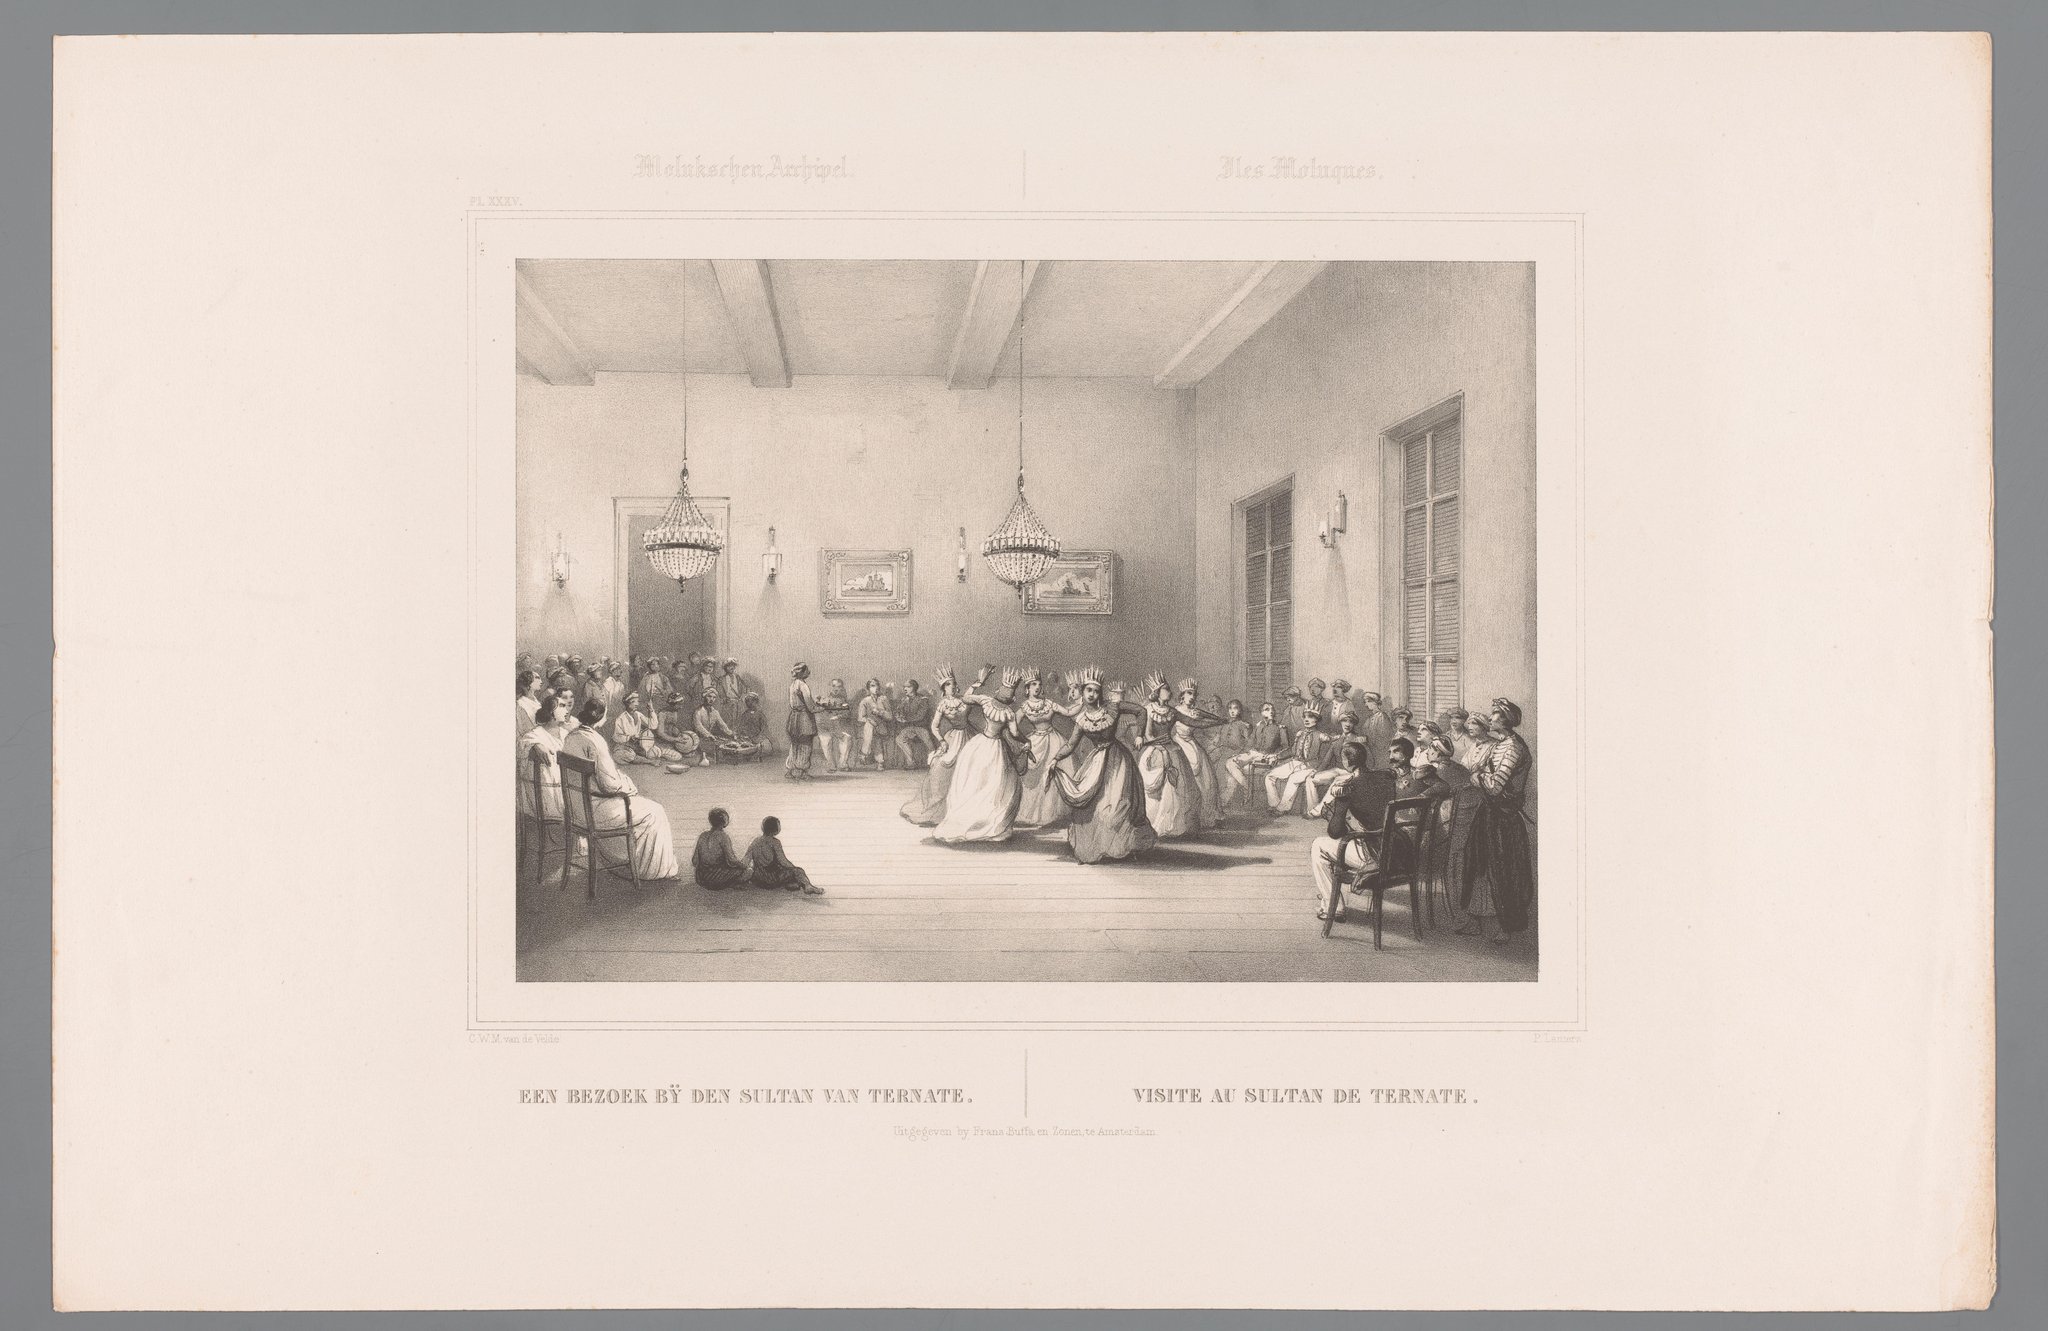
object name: print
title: Molukschen archipel / Iles Moluques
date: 1847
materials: paper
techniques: lithograph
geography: amsterdam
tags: chandelier, candelabrum, interior of the house, group of women (folk dancing)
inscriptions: collector's mark: Lugt 2228